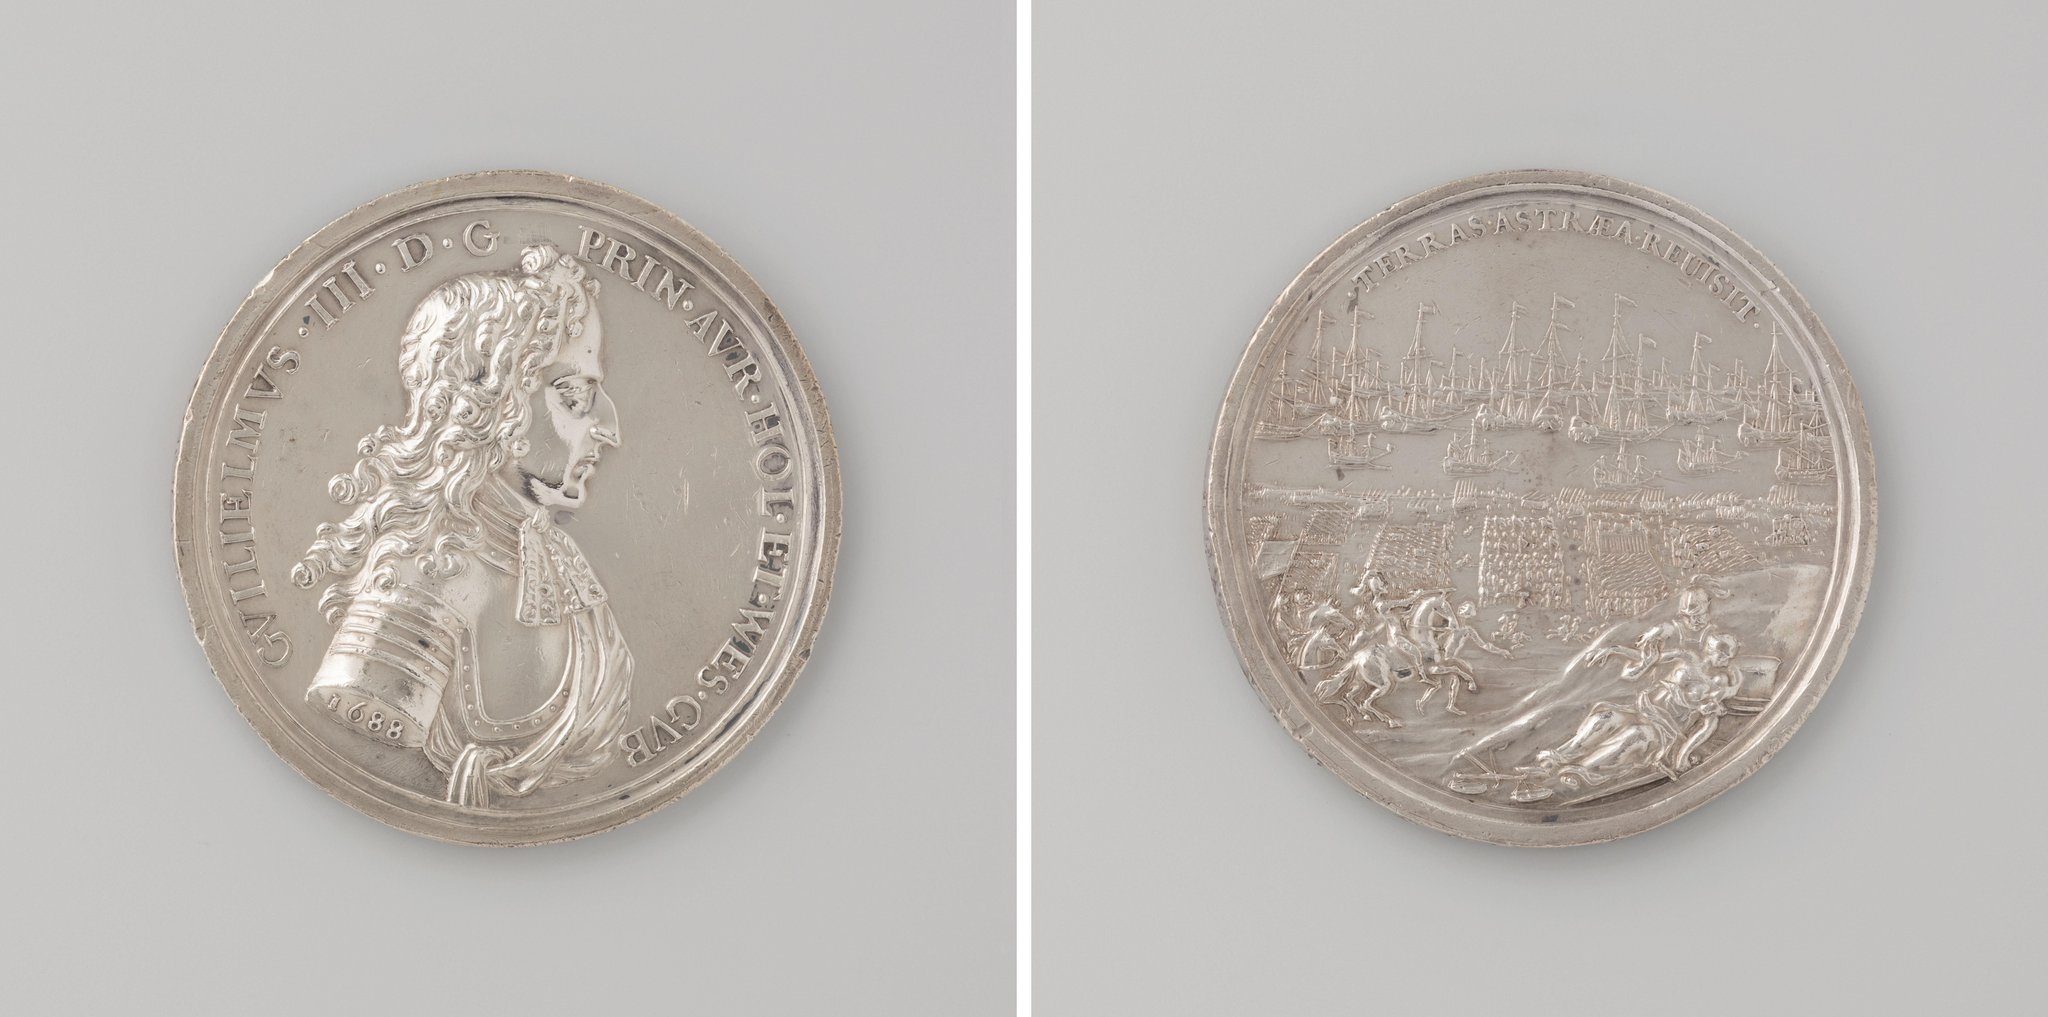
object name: history medal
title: Landing van Willem III bij Torbay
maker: george bower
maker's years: 1650-1690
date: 1688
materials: silver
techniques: striking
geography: london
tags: the hague, william iii (prince of orange and king of england, scotland, and ireland), england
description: Zilveren penning. Voorzijde: borststuk man binnen omschrift. Keerzijde: landing van troepen bij Torbay, op voorgrond helpt soldaat flauwgevallen Rechtvaardigheid overeind binnen omschrift; randschrift